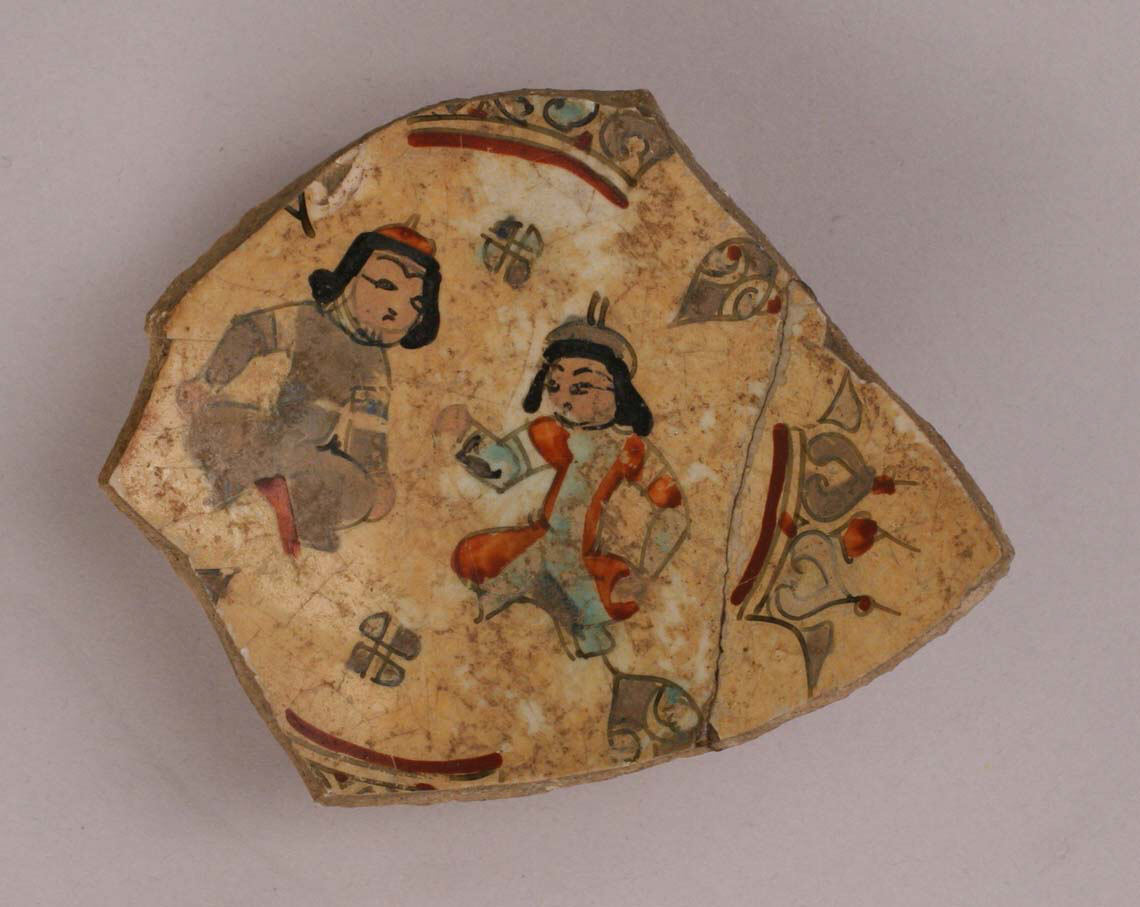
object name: fragment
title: Fragment of a Bowl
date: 1101-1300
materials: stonepaste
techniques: overglaze, painting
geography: iran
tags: men